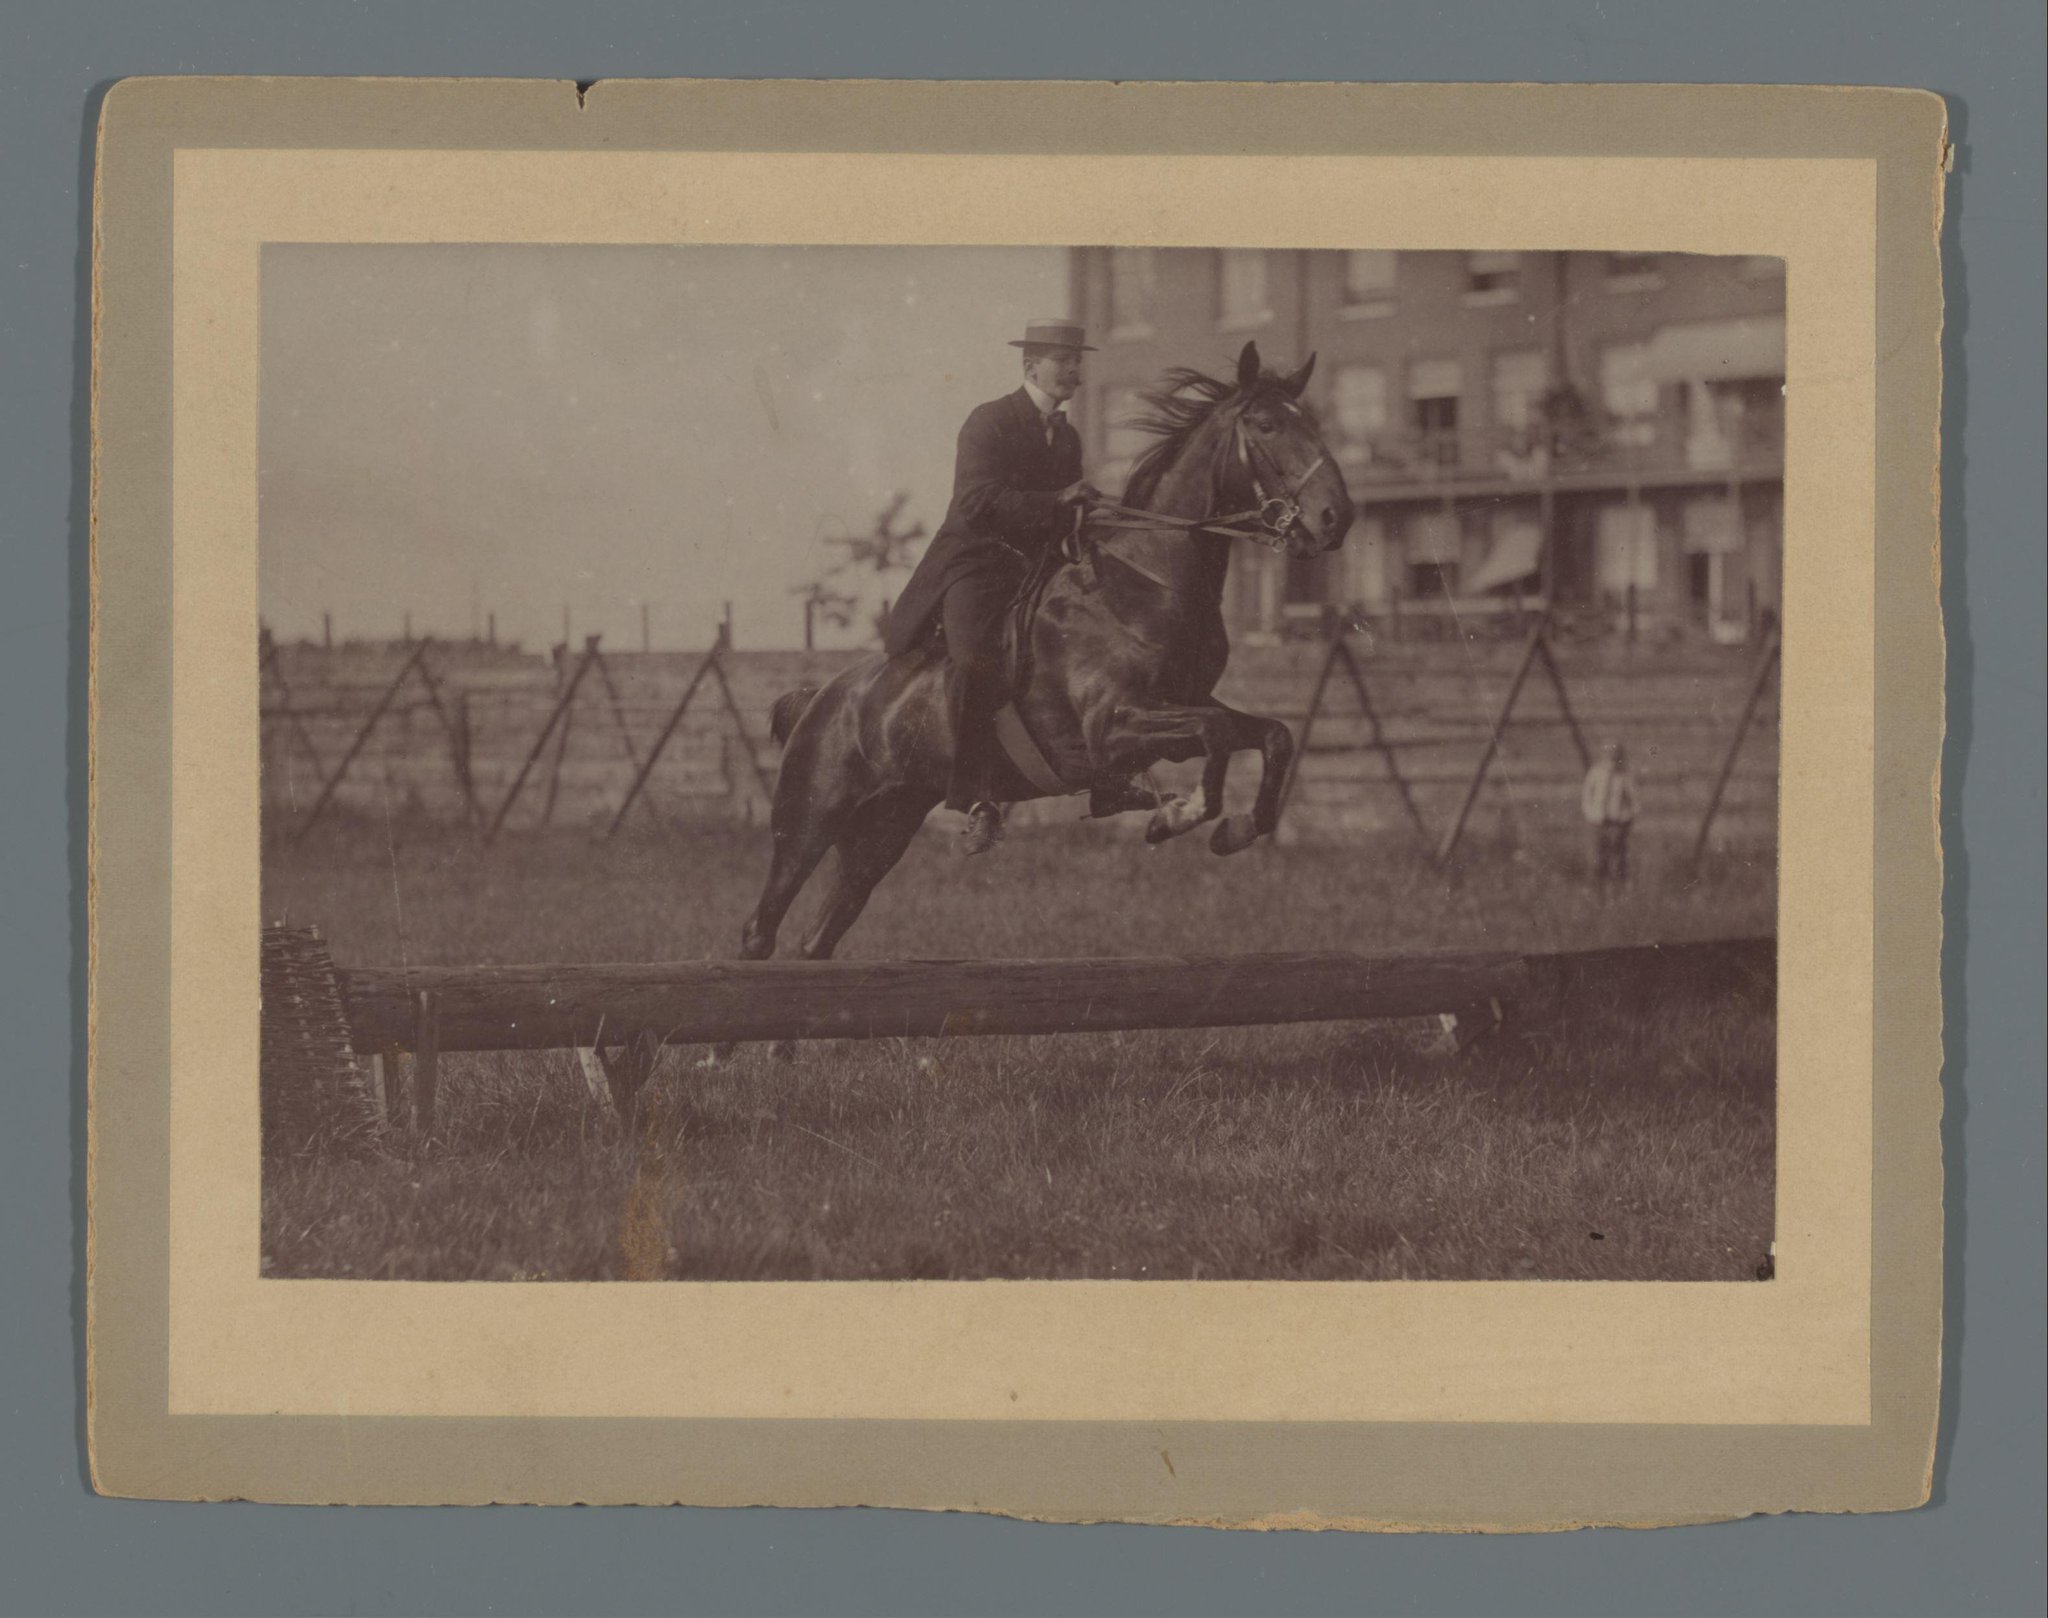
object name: photograph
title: Henk van de Berg neemt op zijn paard Bobbie een horde op het veld achter het Rijksmuseum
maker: hendrik herman van den berg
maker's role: amateurfotograaf, jurist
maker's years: 1875-1944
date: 1896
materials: cardboard, photographic support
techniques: collodion silver print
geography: amsterdam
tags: rotterdam, amsterdam, norbertus petrus van den berg (1831-1917), riding a horse, ass, or mule; rider, horseman